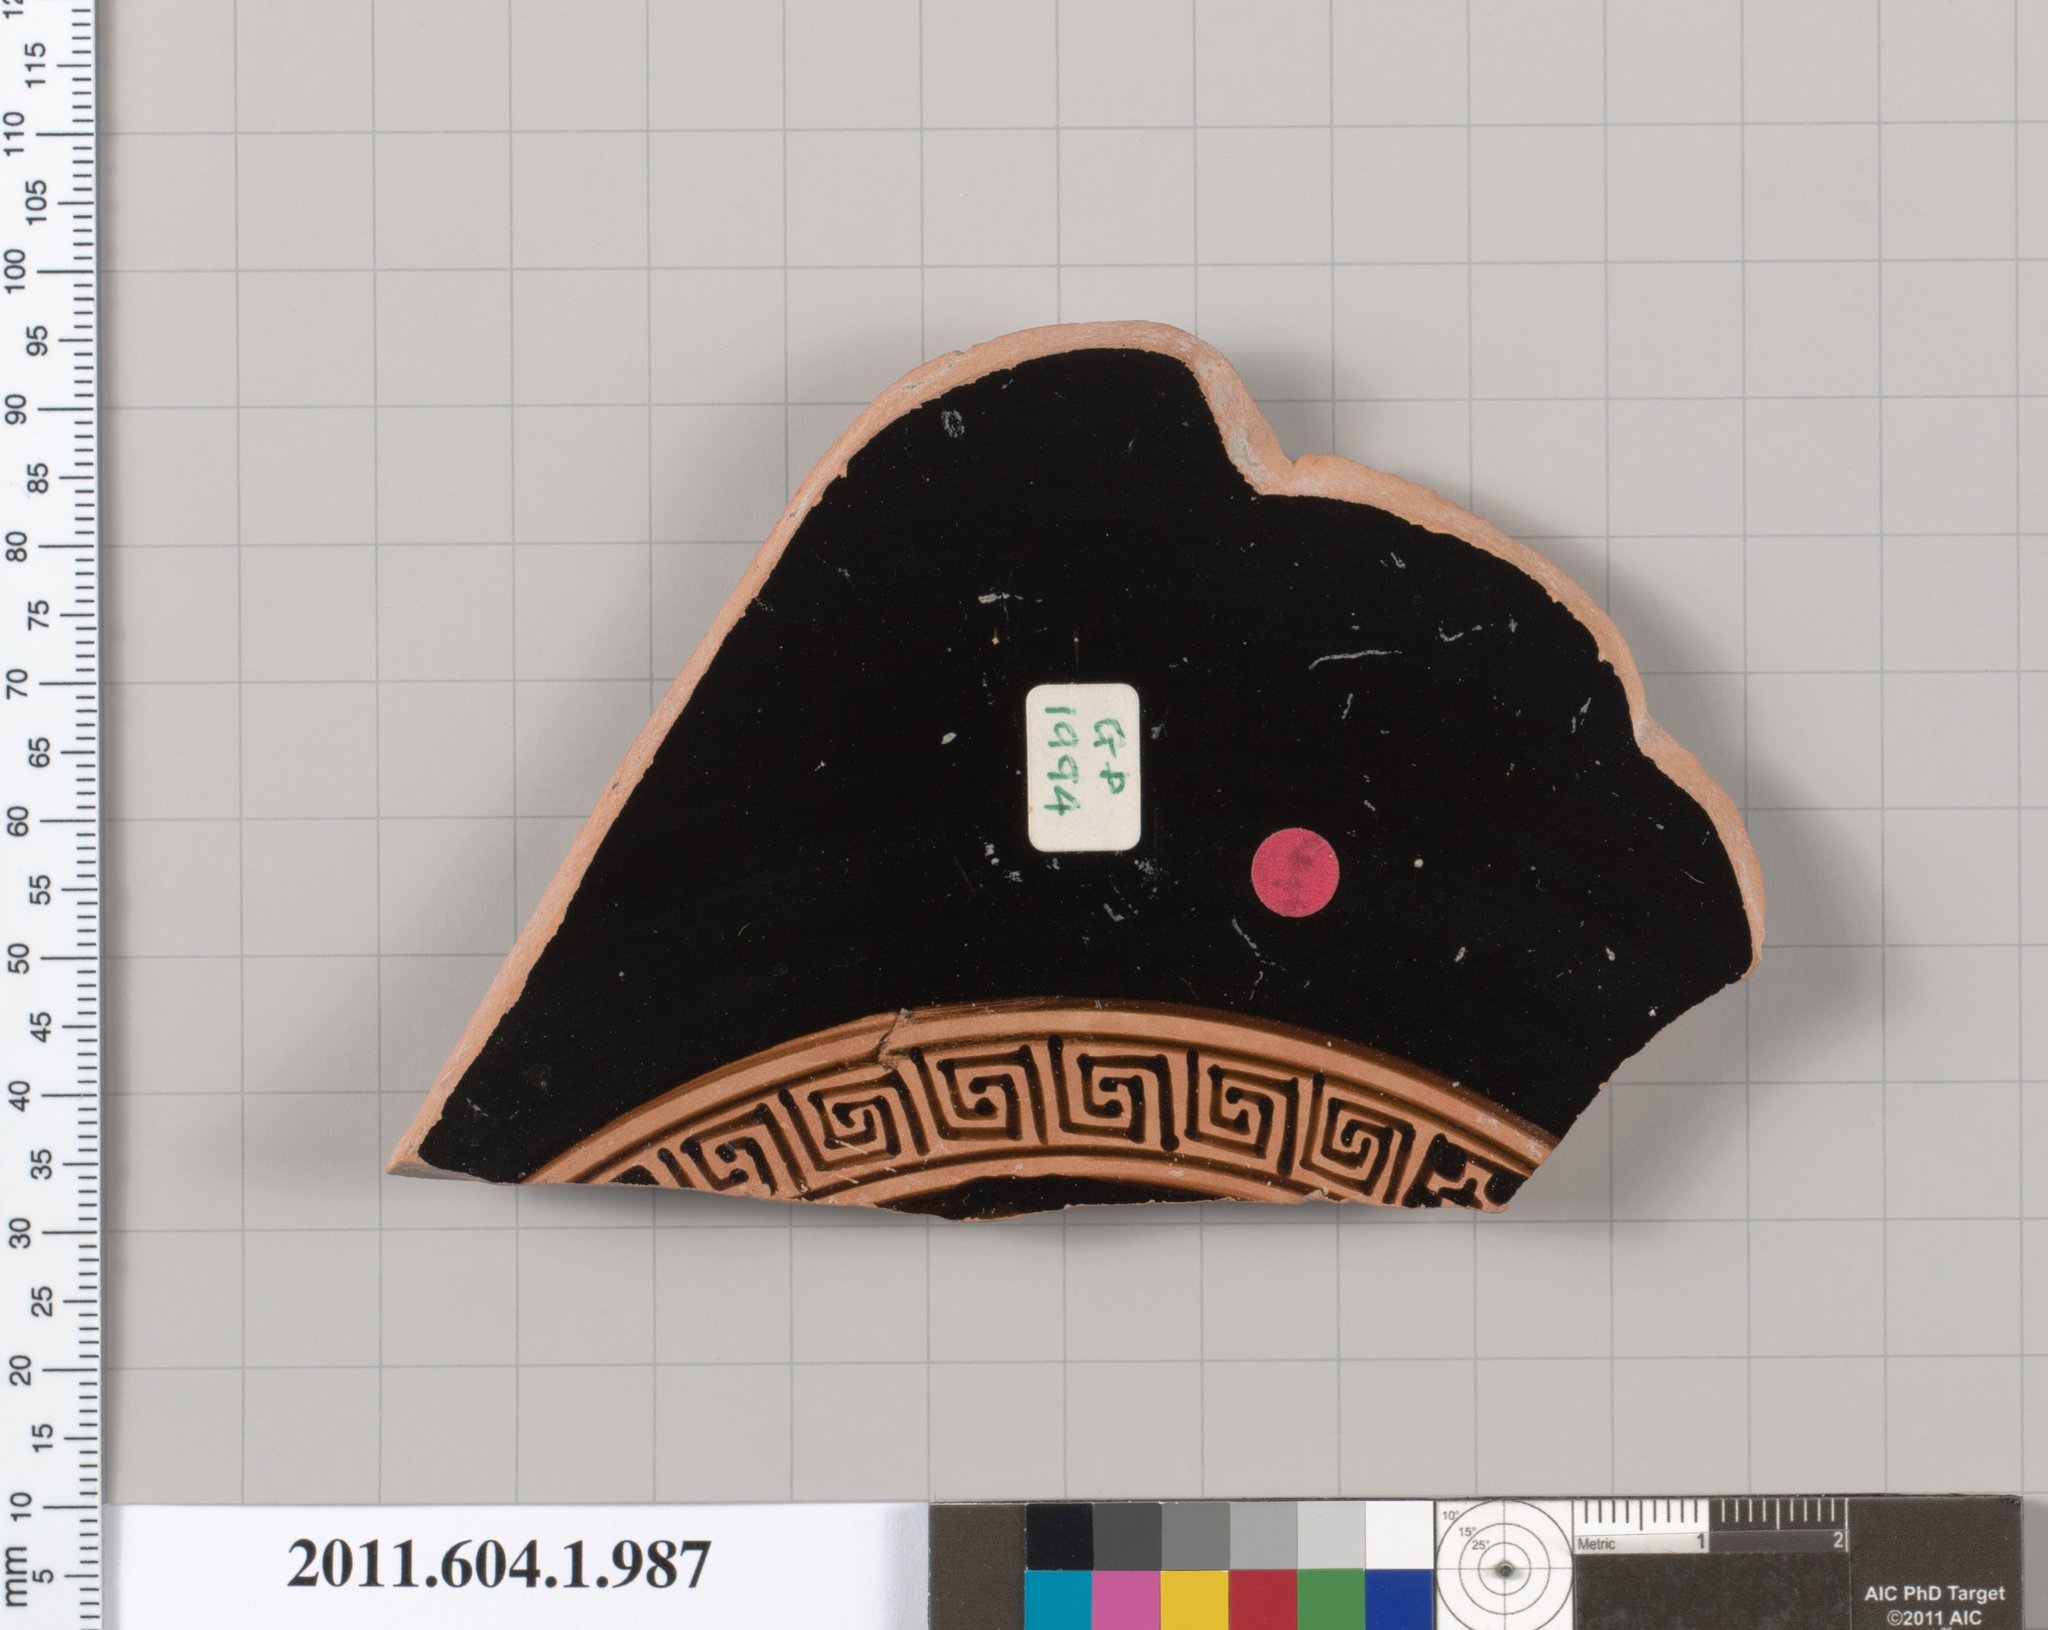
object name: kylix fragment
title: Terracotta fragment of a kylix (drinking cup)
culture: greek, attic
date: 475-451 BCE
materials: terracotta